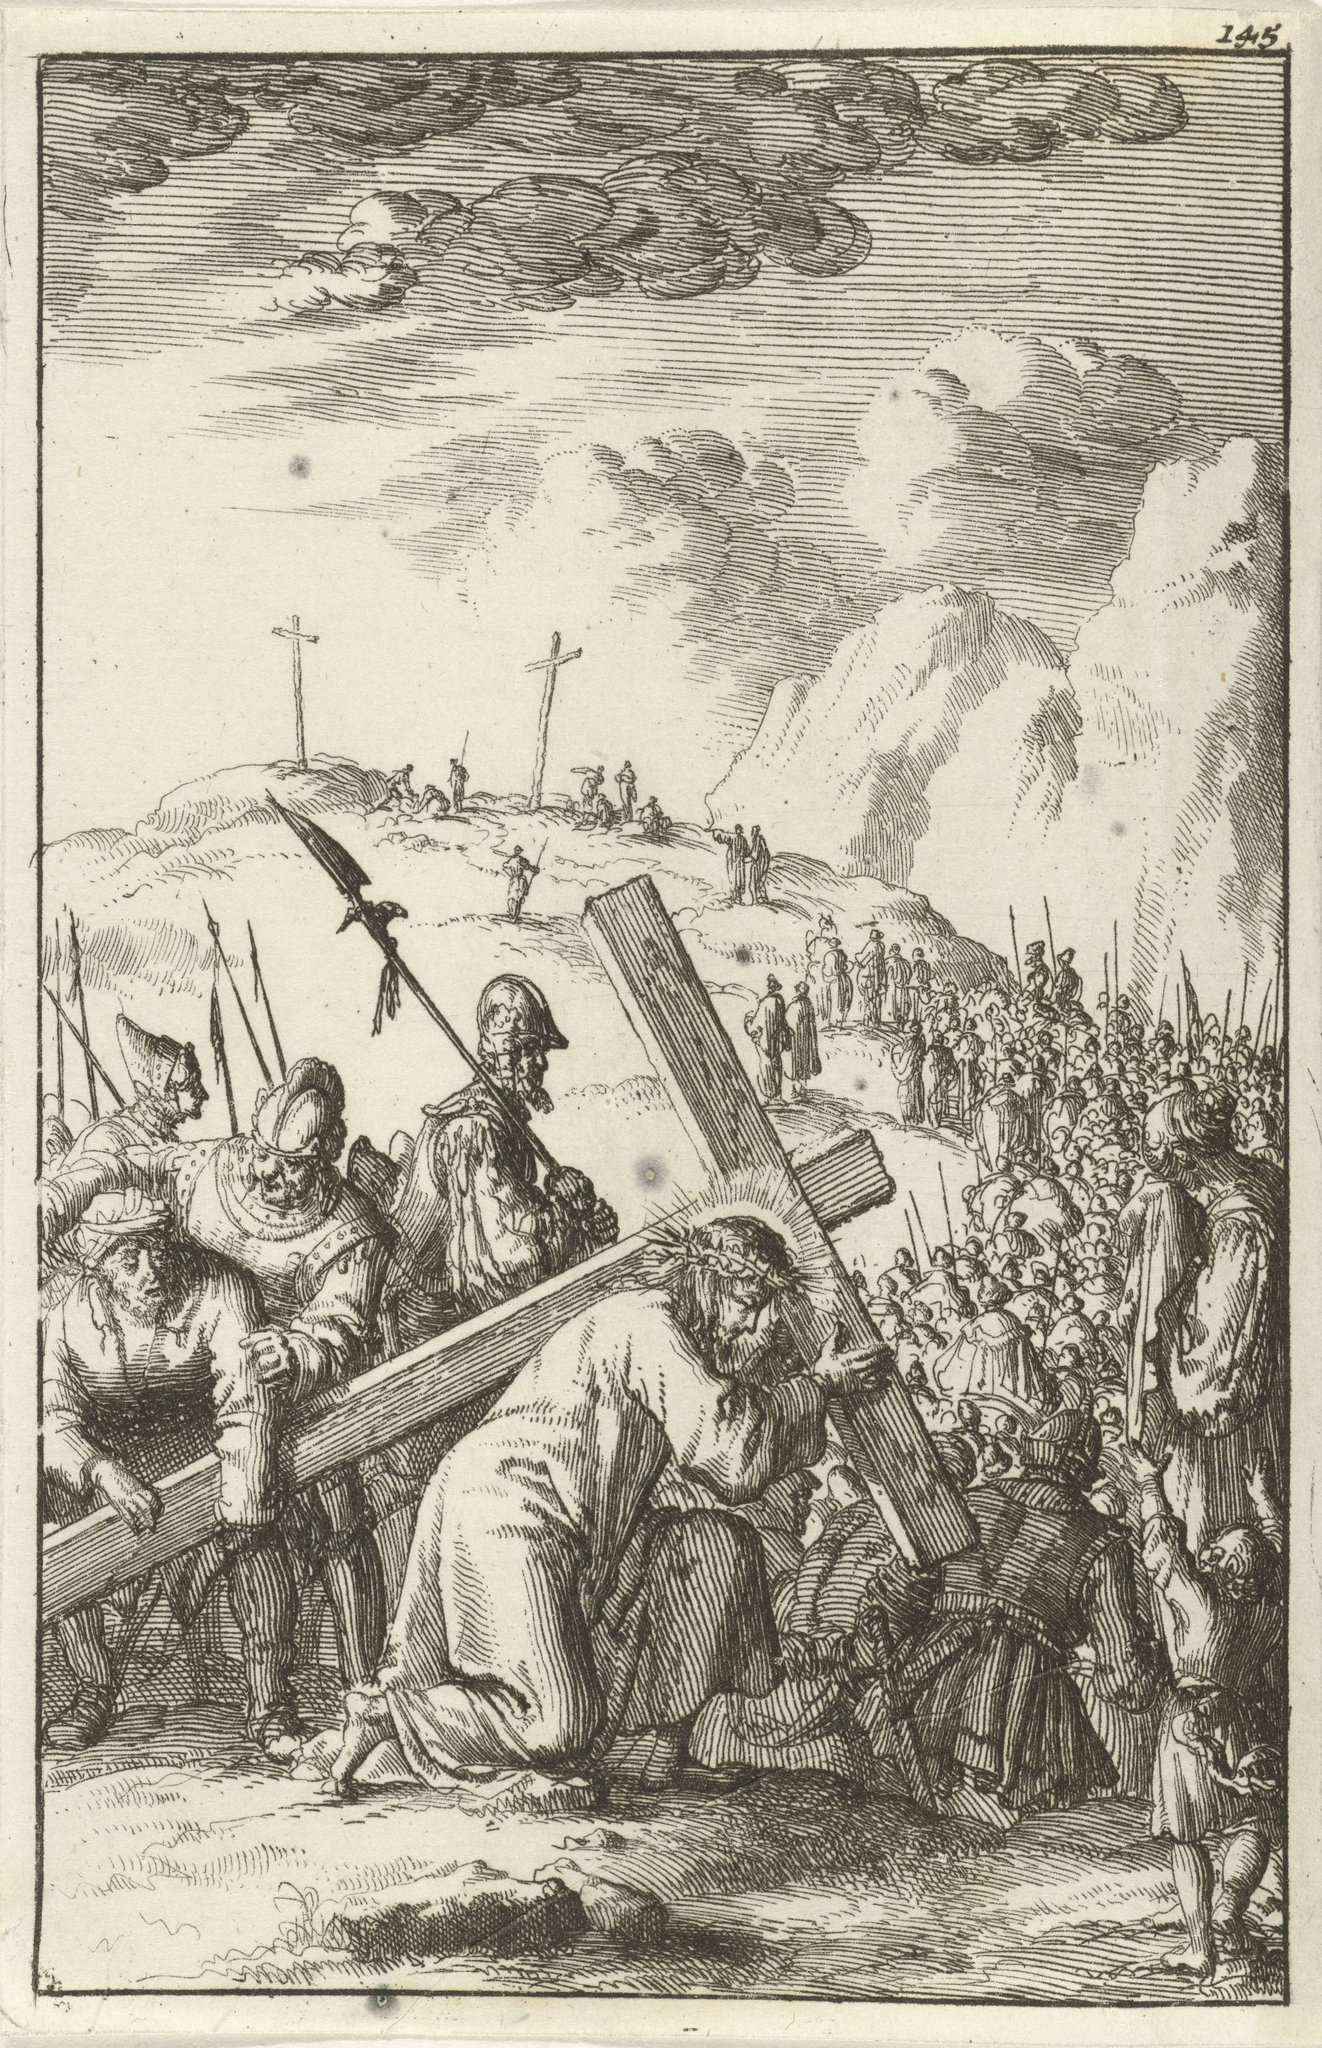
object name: book illustration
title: Kruisdraging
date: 1684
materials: paper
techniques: etching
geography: amsterdam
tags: carrying of the cross: christ bearing the cross, alone or with the help of others (e.g. simon the cyrenian)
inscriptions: collector's mark: Lugt 2228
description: Illustratie uit: Langedult, Petrus. Christus lydende, en verheerlykt. Het allerheylsaamste treur-spel. Amsterdam: Aart Dircksz Oossaan, 1684.